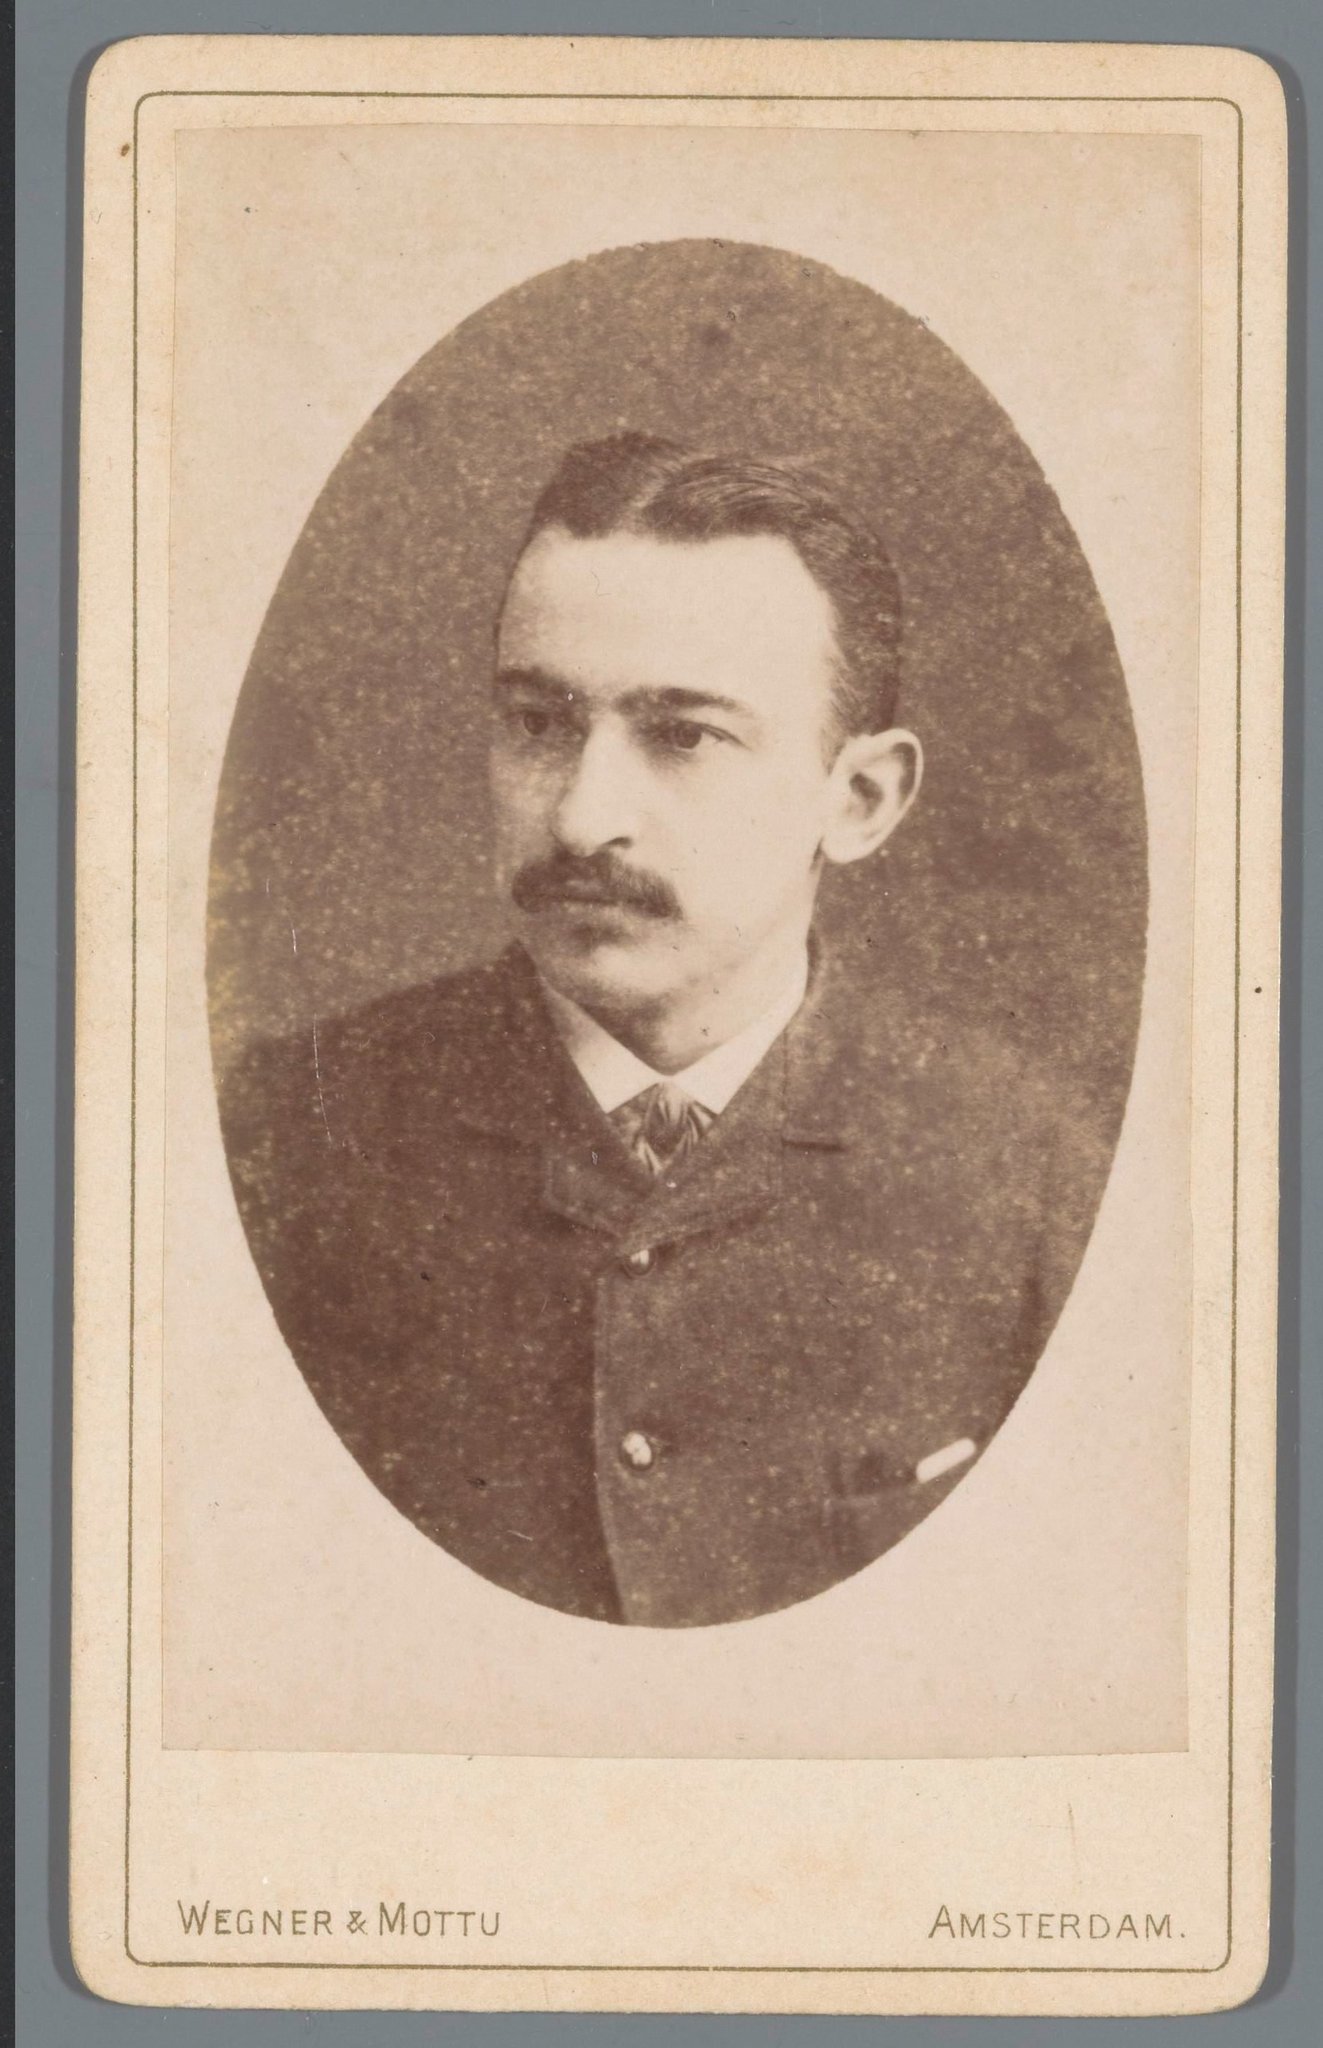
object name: photograph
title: Portret van een onbekende man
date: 1885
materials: cardboard, paper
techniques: albumen print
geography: amsterdam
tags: adult man, anonymous historical person portrayed, amsterdam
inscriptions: inscription: ‘Als vriendschappelijk aandenken/ aan mijn jonge vriend P.C. van der/ Waeyen Pieterszen./ 25/9 '85./ [...]’, inscription: ‘WEgner & Mottu Amsterdam’, inscription: ‘Photographisch Artistisch Atelier/ van/ Wegner & Mottu/ Rokin over de Bank 138./ Amsterdam./ Het cliché wordt voor verdere/ bestellingen bewaard.’